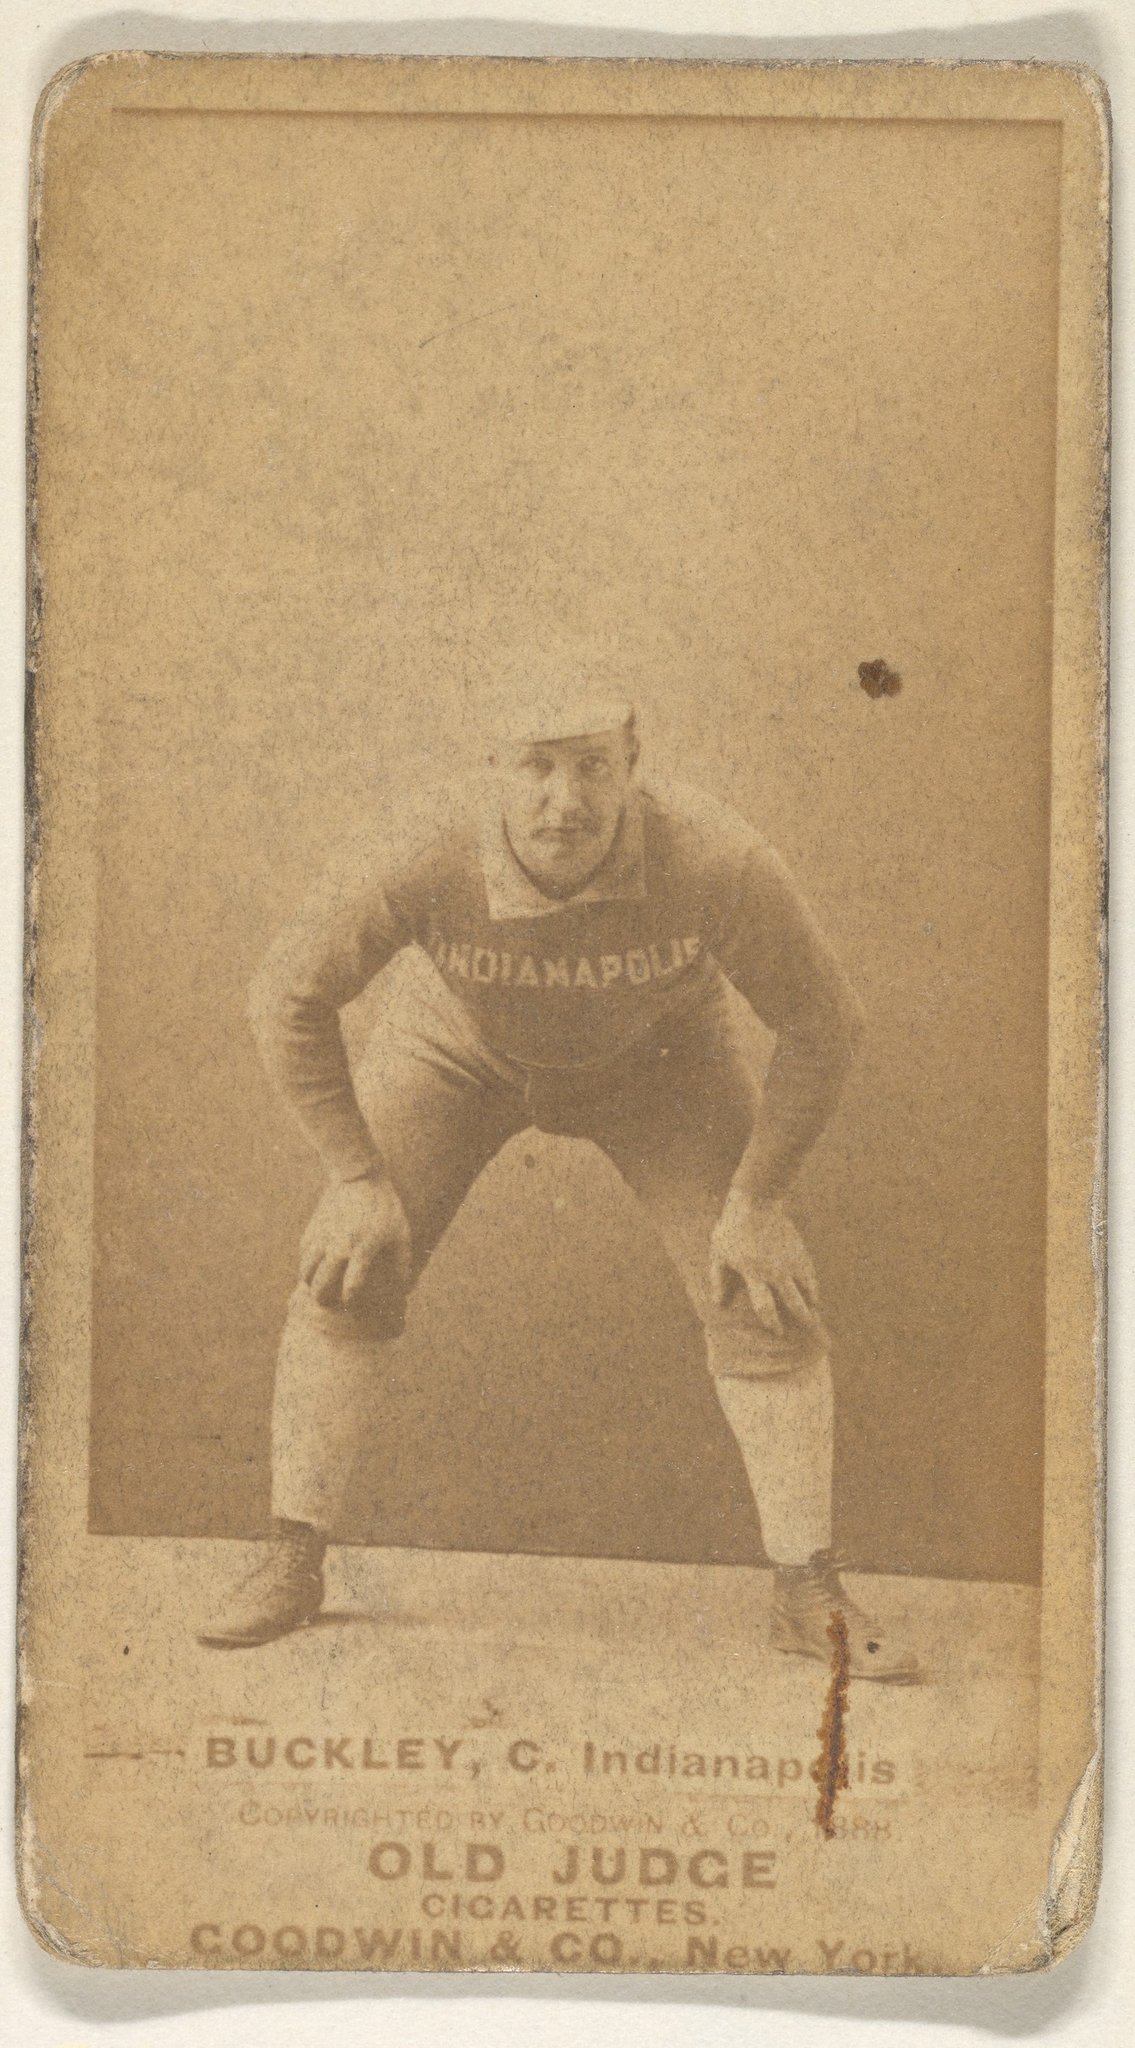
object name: baseball card, photograph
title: Buckley, Catcher, Indianapolis, from the Old Judge series (N172) for Old Judge Cigarettes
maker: goodwin & company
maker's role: publisher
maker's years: 1850-1950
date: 1887-1890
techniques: albumen silver print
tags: men,portraits,baseball,athletes